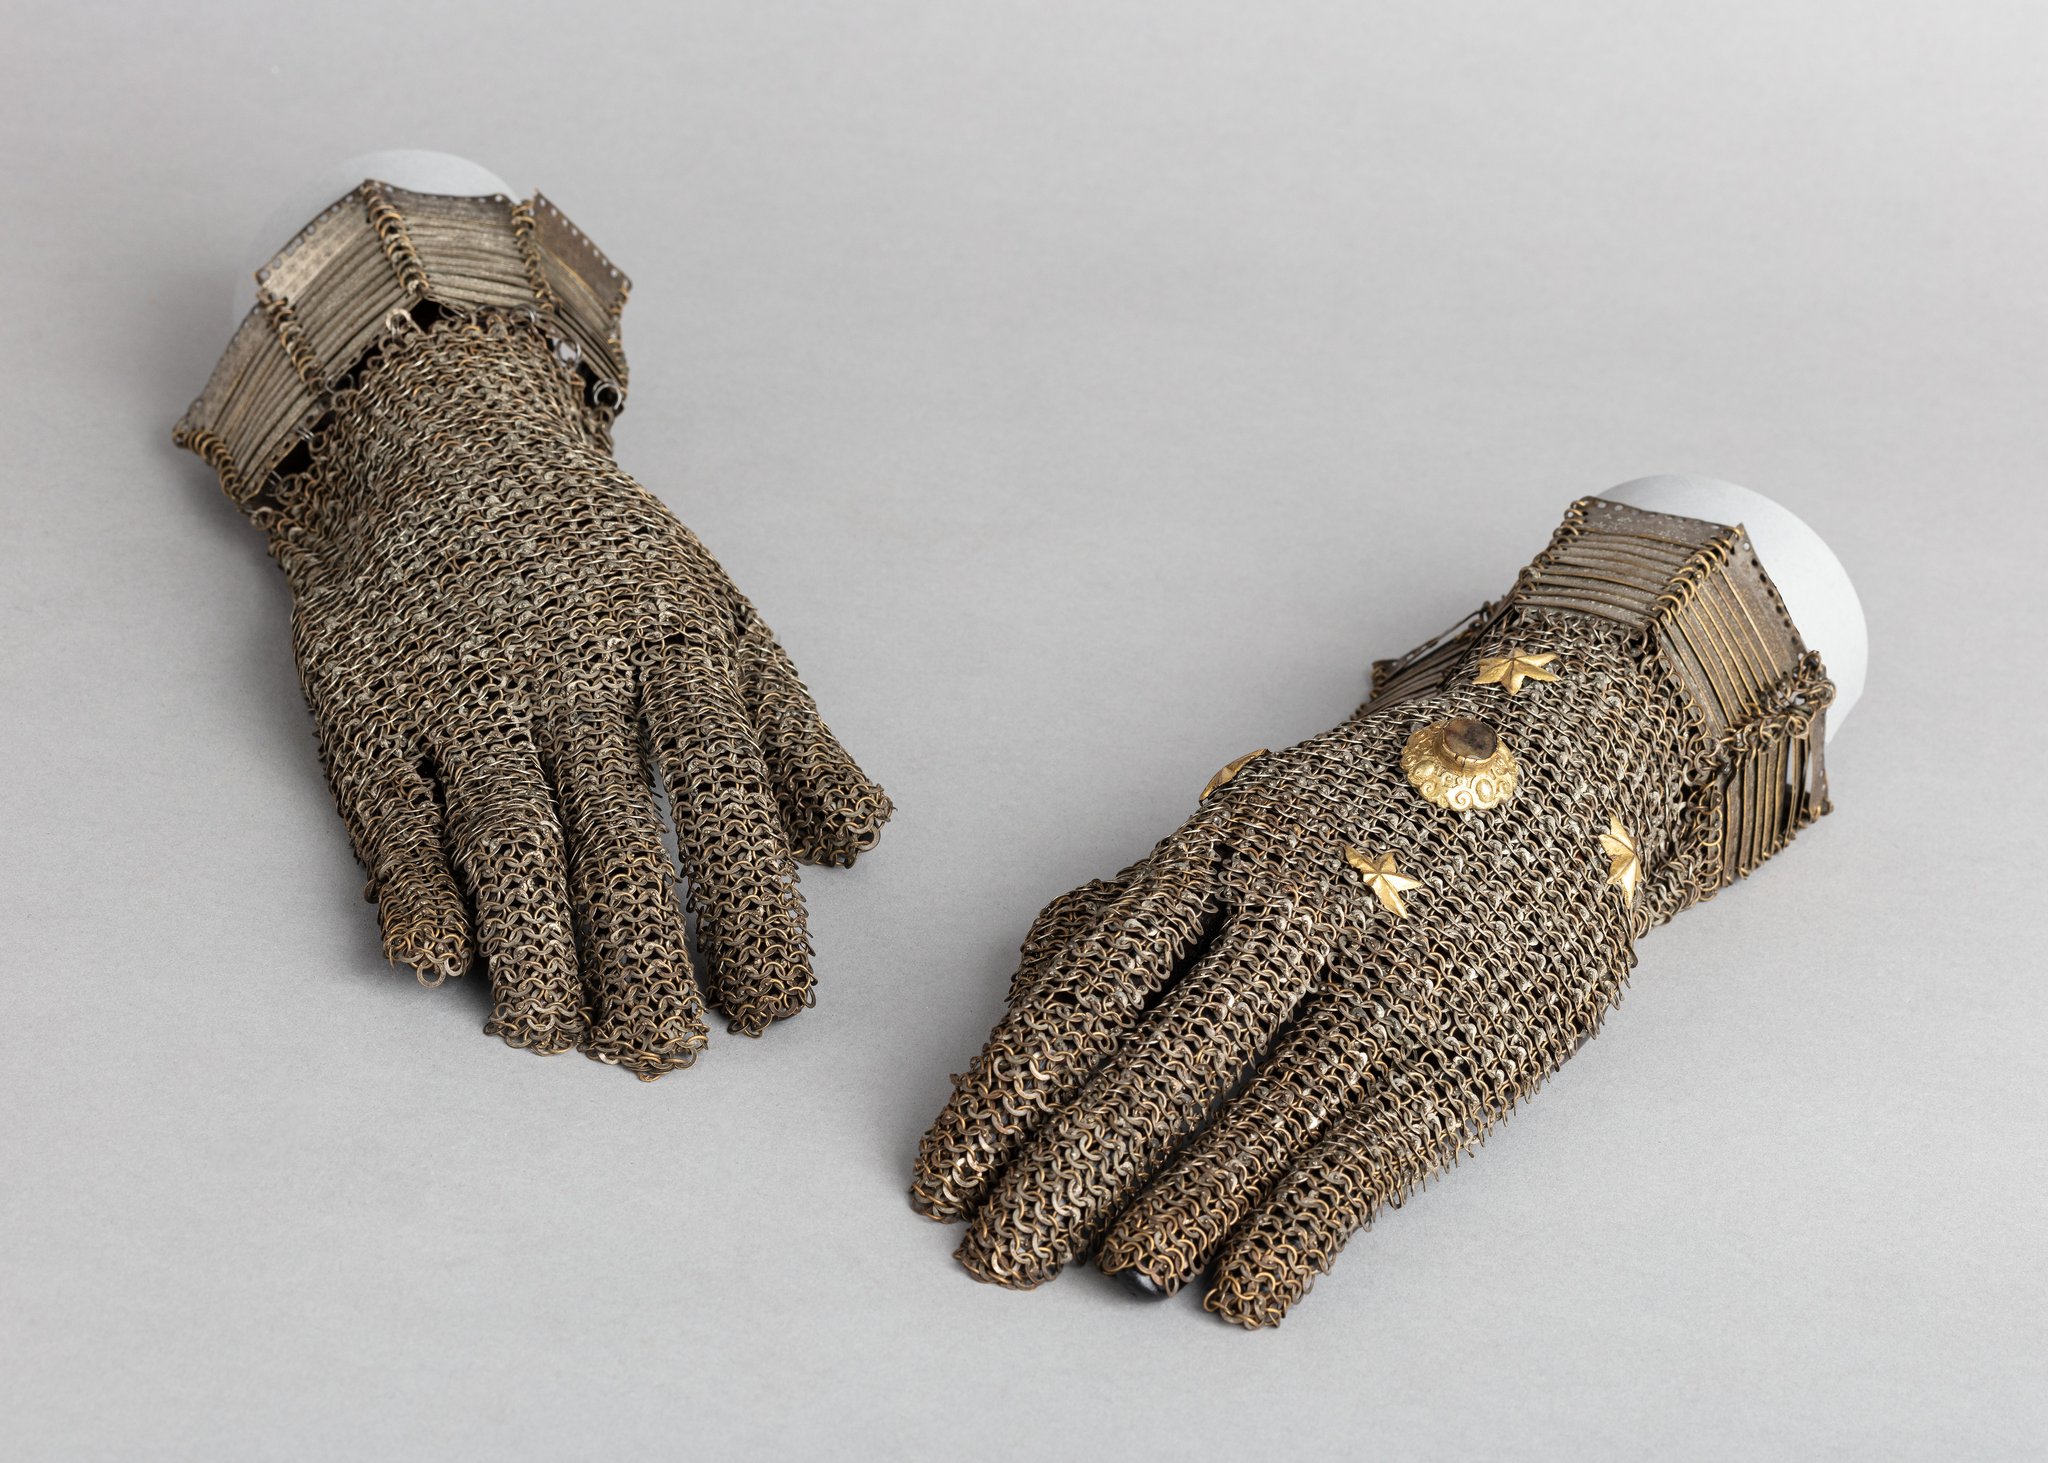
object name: gauntlet of mail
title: Gauntlets of Mail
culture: hungarian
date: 1601-1700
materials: gold, steel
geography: hungary